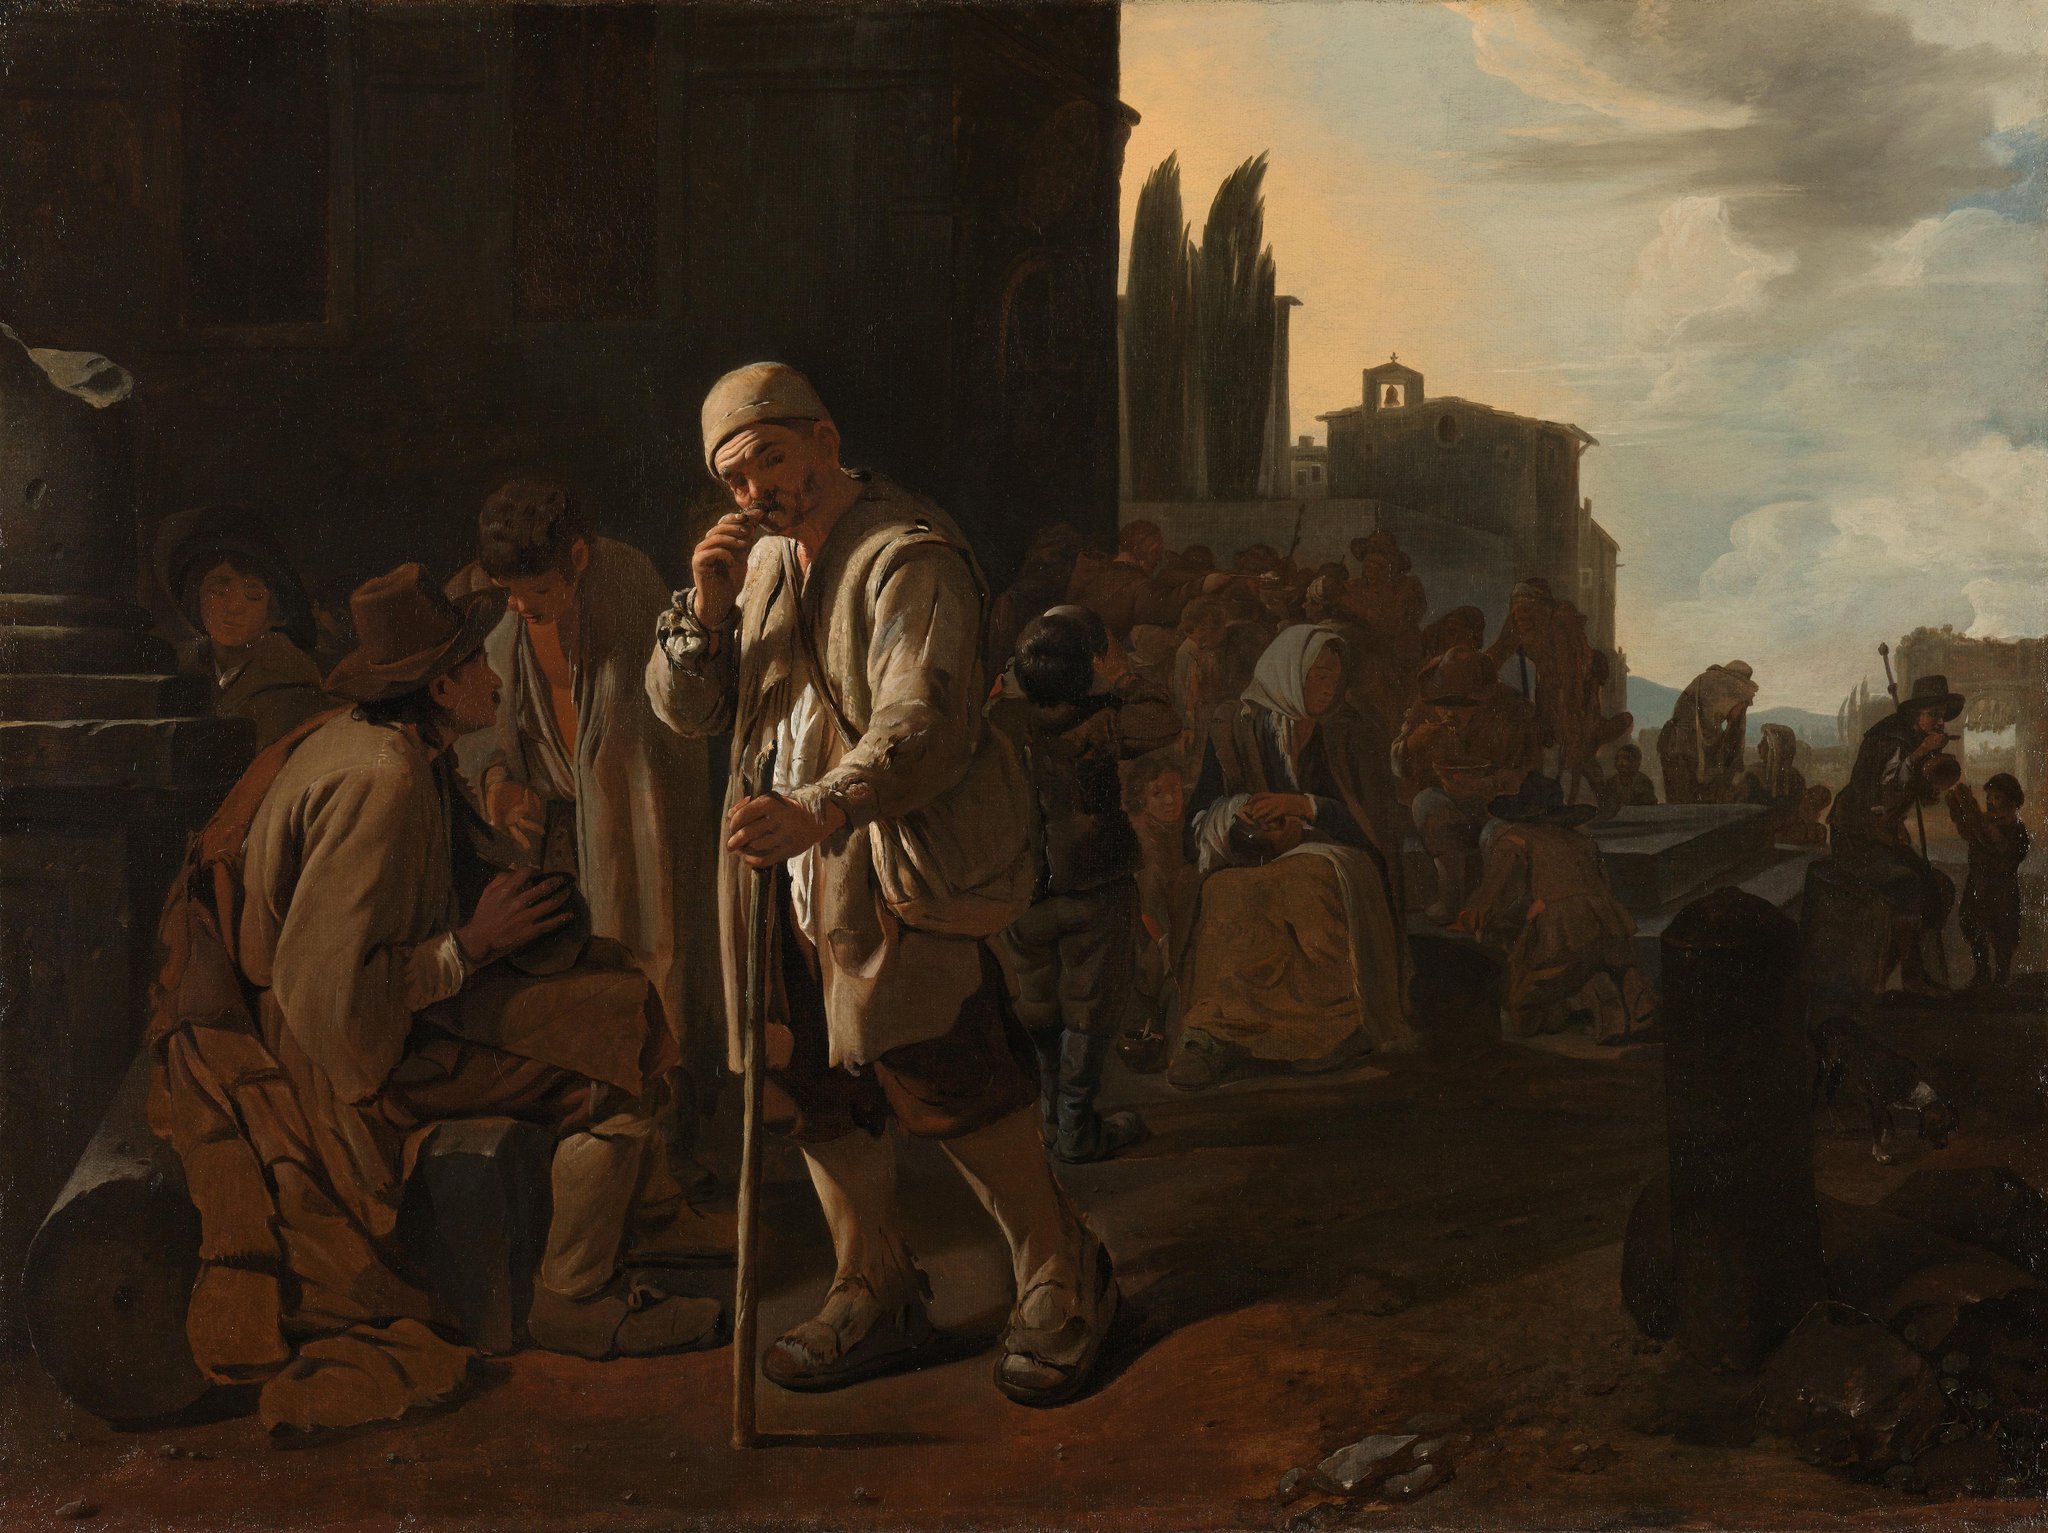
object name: painting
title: Feeding the Hungry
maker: michael sweerts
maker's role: painter, print maker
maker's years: 1618-1664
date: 1646-1649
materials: canvas, oil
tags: feeding the hungry, 'esuriens cibatur' ~ one of the (seven) acts of mercy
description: In the Catholic Church, the ‘Seven Works of Mercy’ served as a guiding principle for acts of human kindness. They are based on Christ’s teachings, as described in the Gospel of Matthew. Sweerts painted his series of – four of which four pictures are in the Rijksmuseum – while in Rome. His humble street scenes depict the poorest of the poor with penetrating insight.